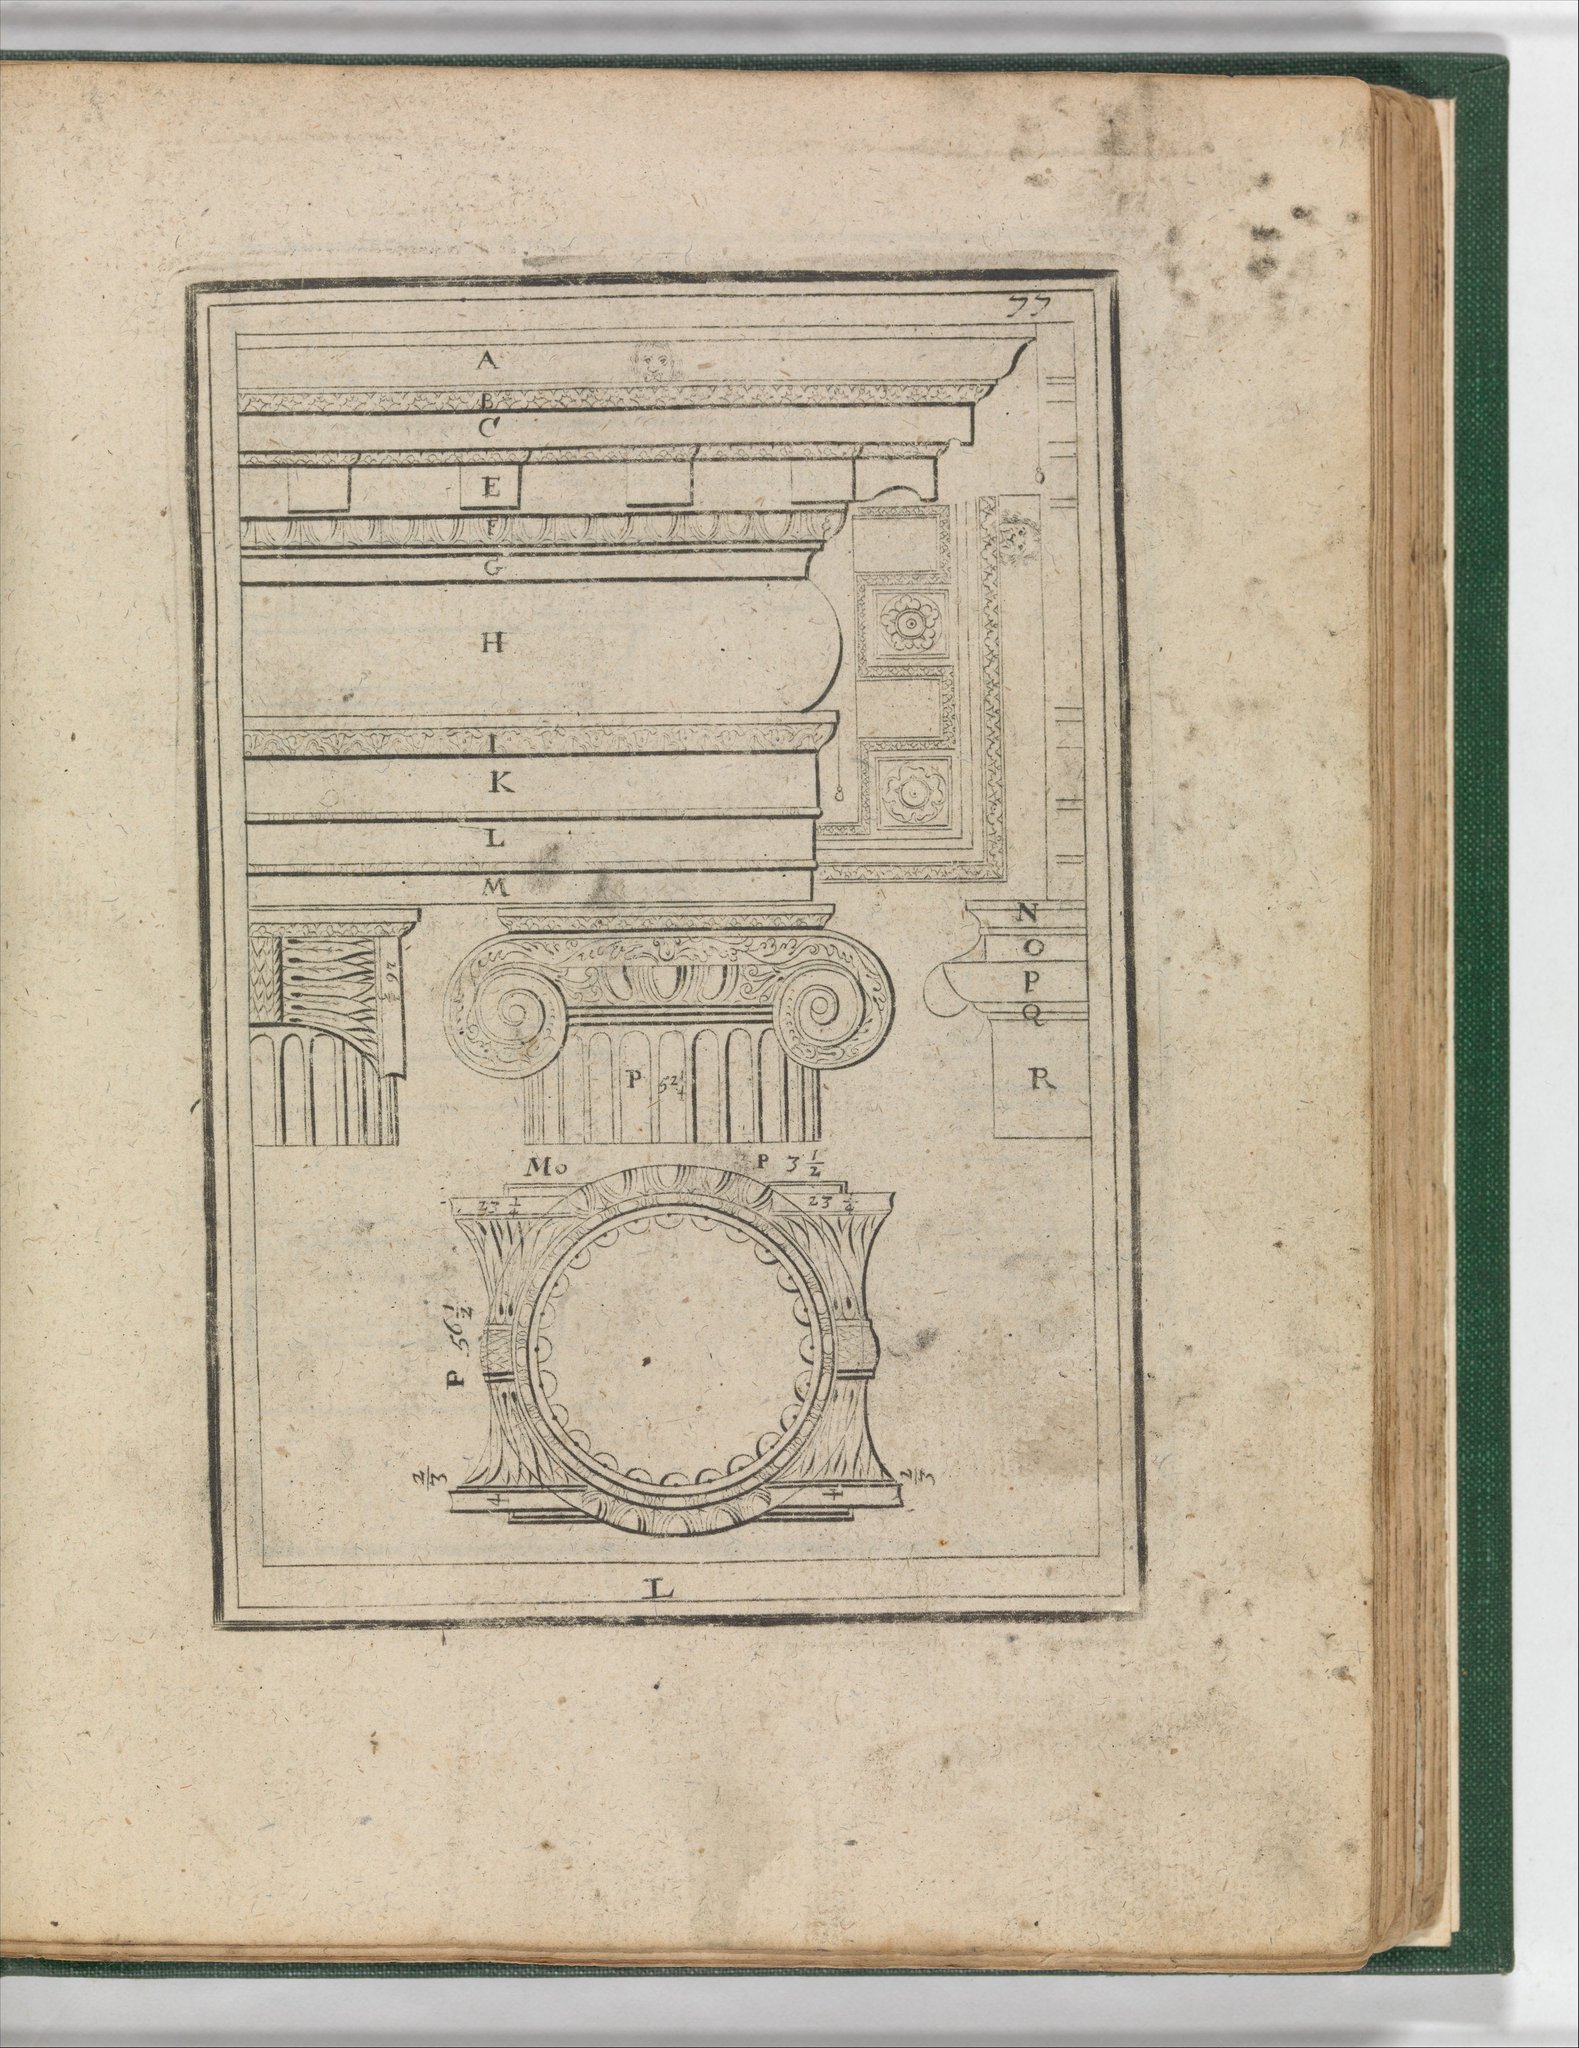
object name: book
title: The First Book of Architecture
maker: andrea palladio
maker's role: author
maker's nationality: italian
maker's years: 1508-1580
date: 1721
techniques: engraving, etching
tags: architecture